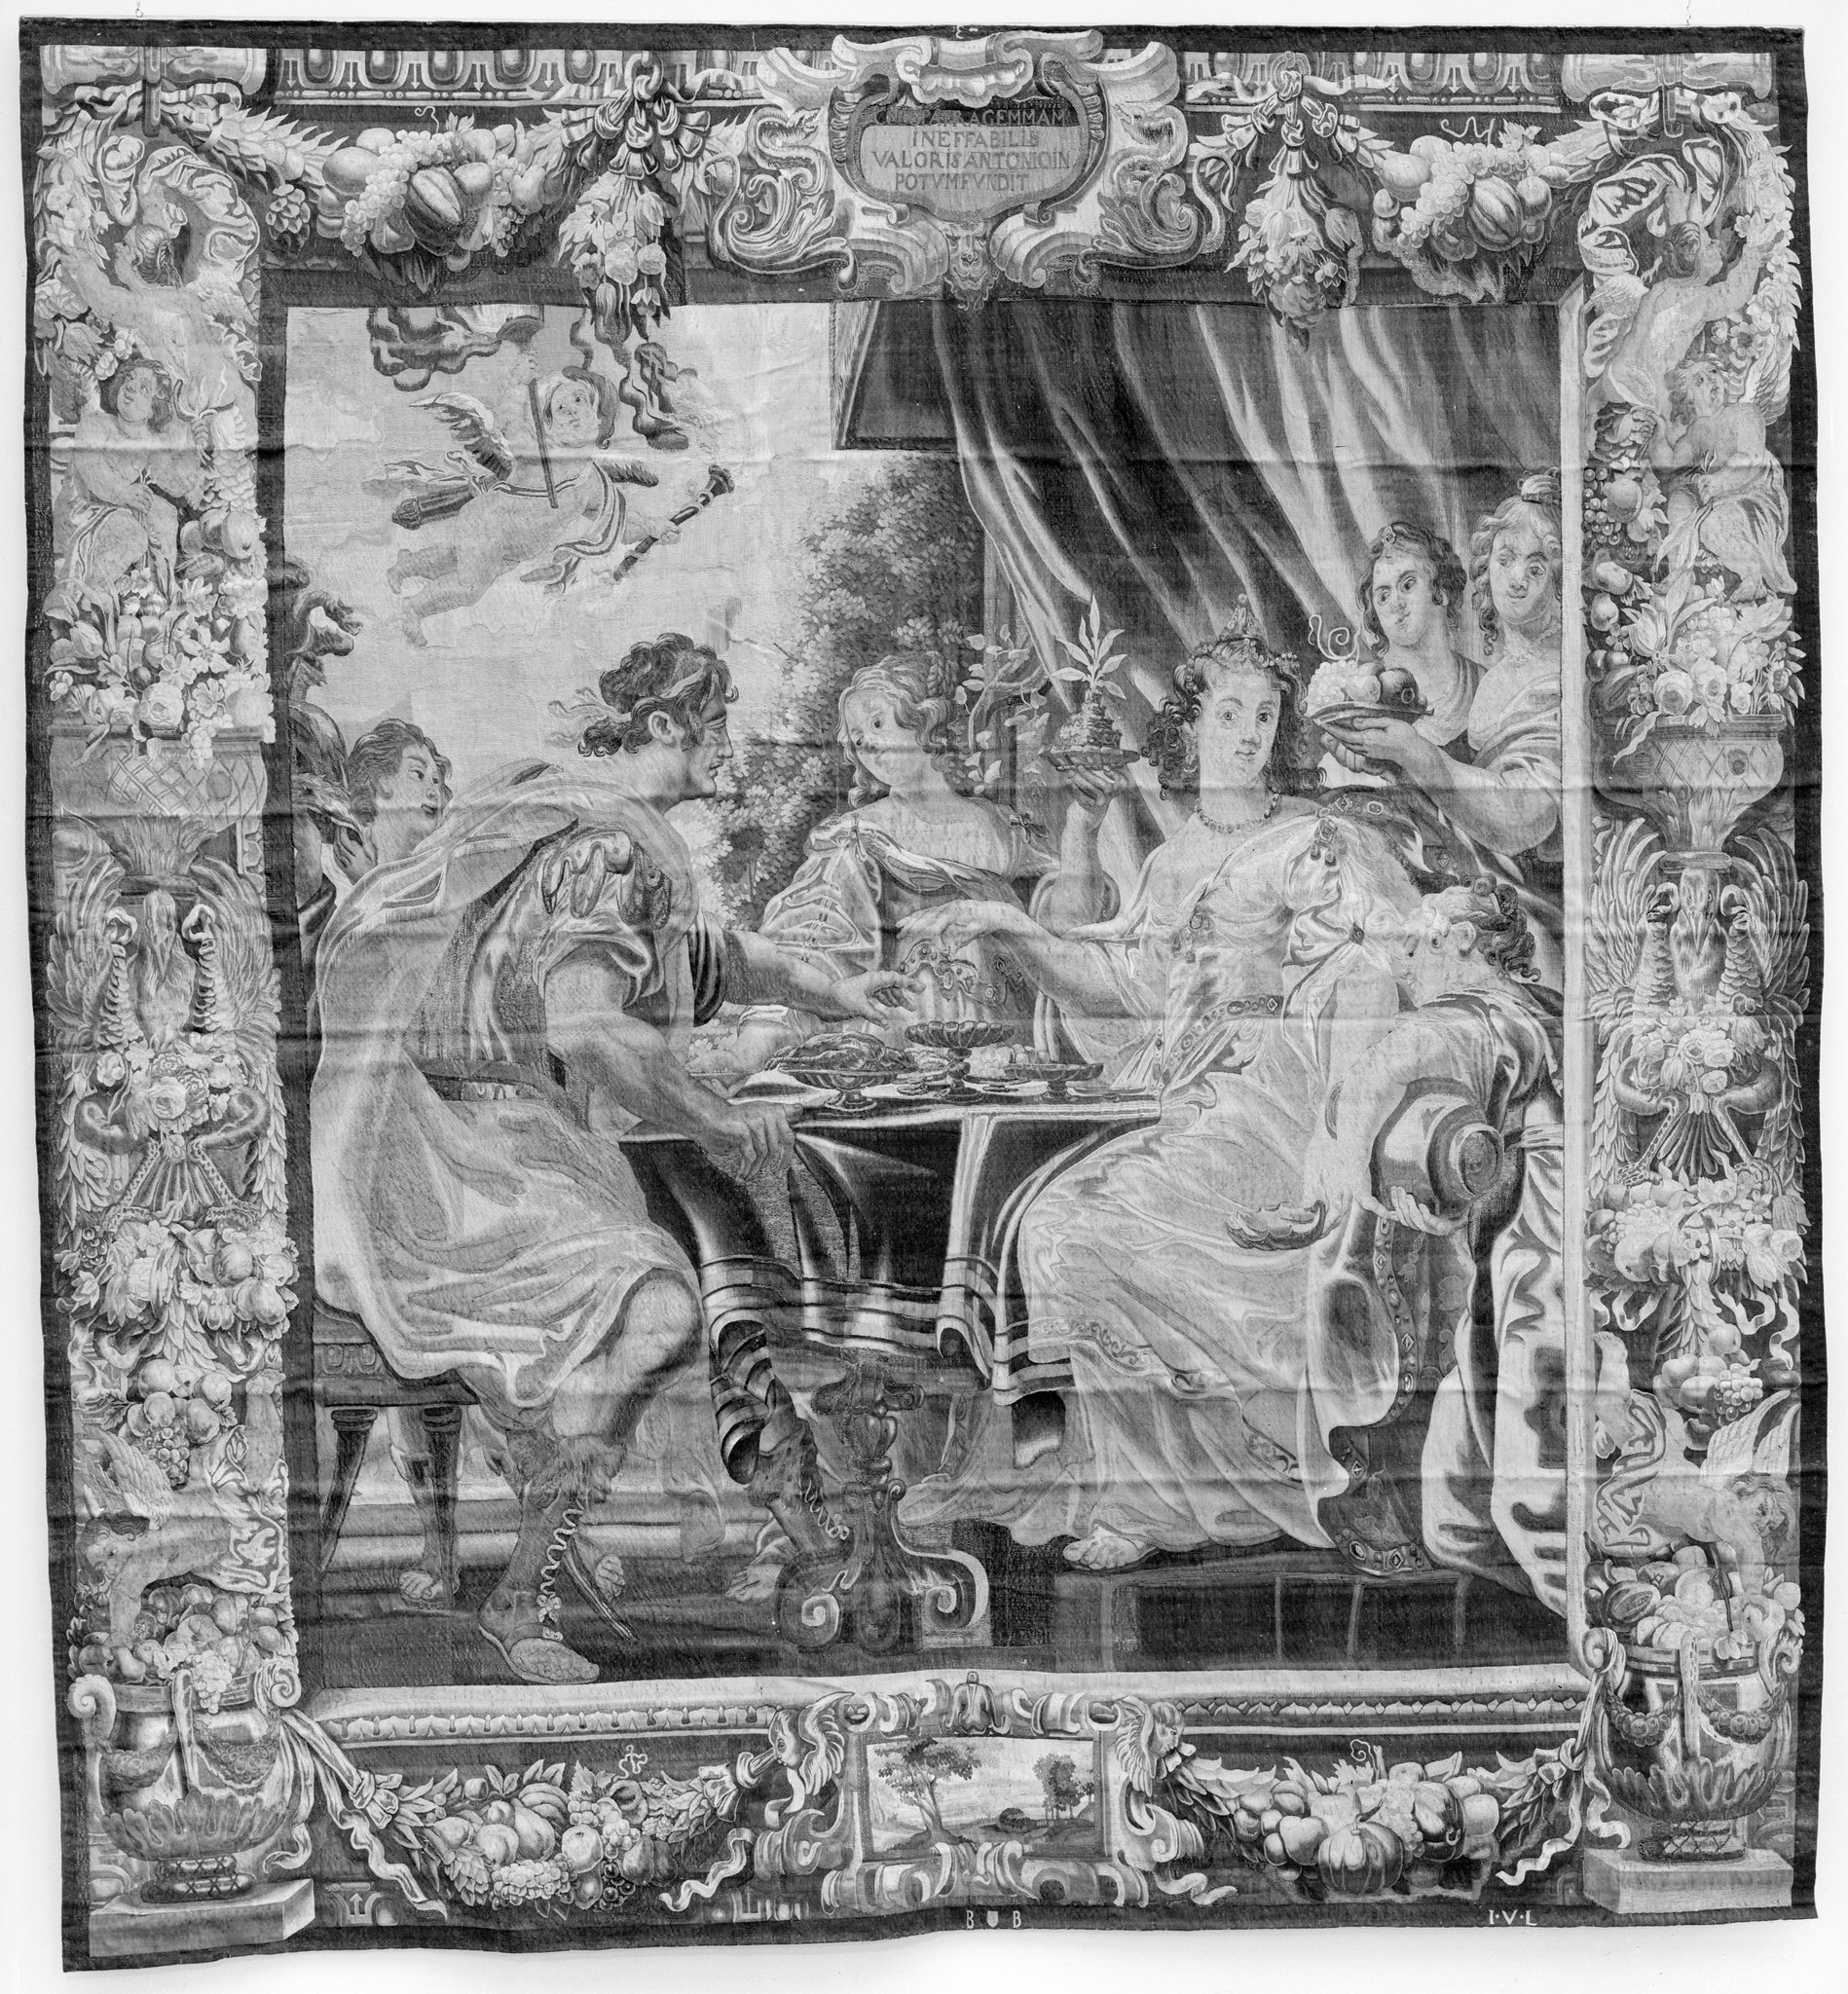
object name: tapestry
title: Cleopatra Dissolving the Pearl from a set of The Story of Antony and Cleopatra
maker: justus van egmont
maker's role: designer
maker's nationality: flemish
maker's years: 1601-1674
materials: silk, silver, silver gilt, thread, wool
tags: fruit,cleopatra,men,women,cupid